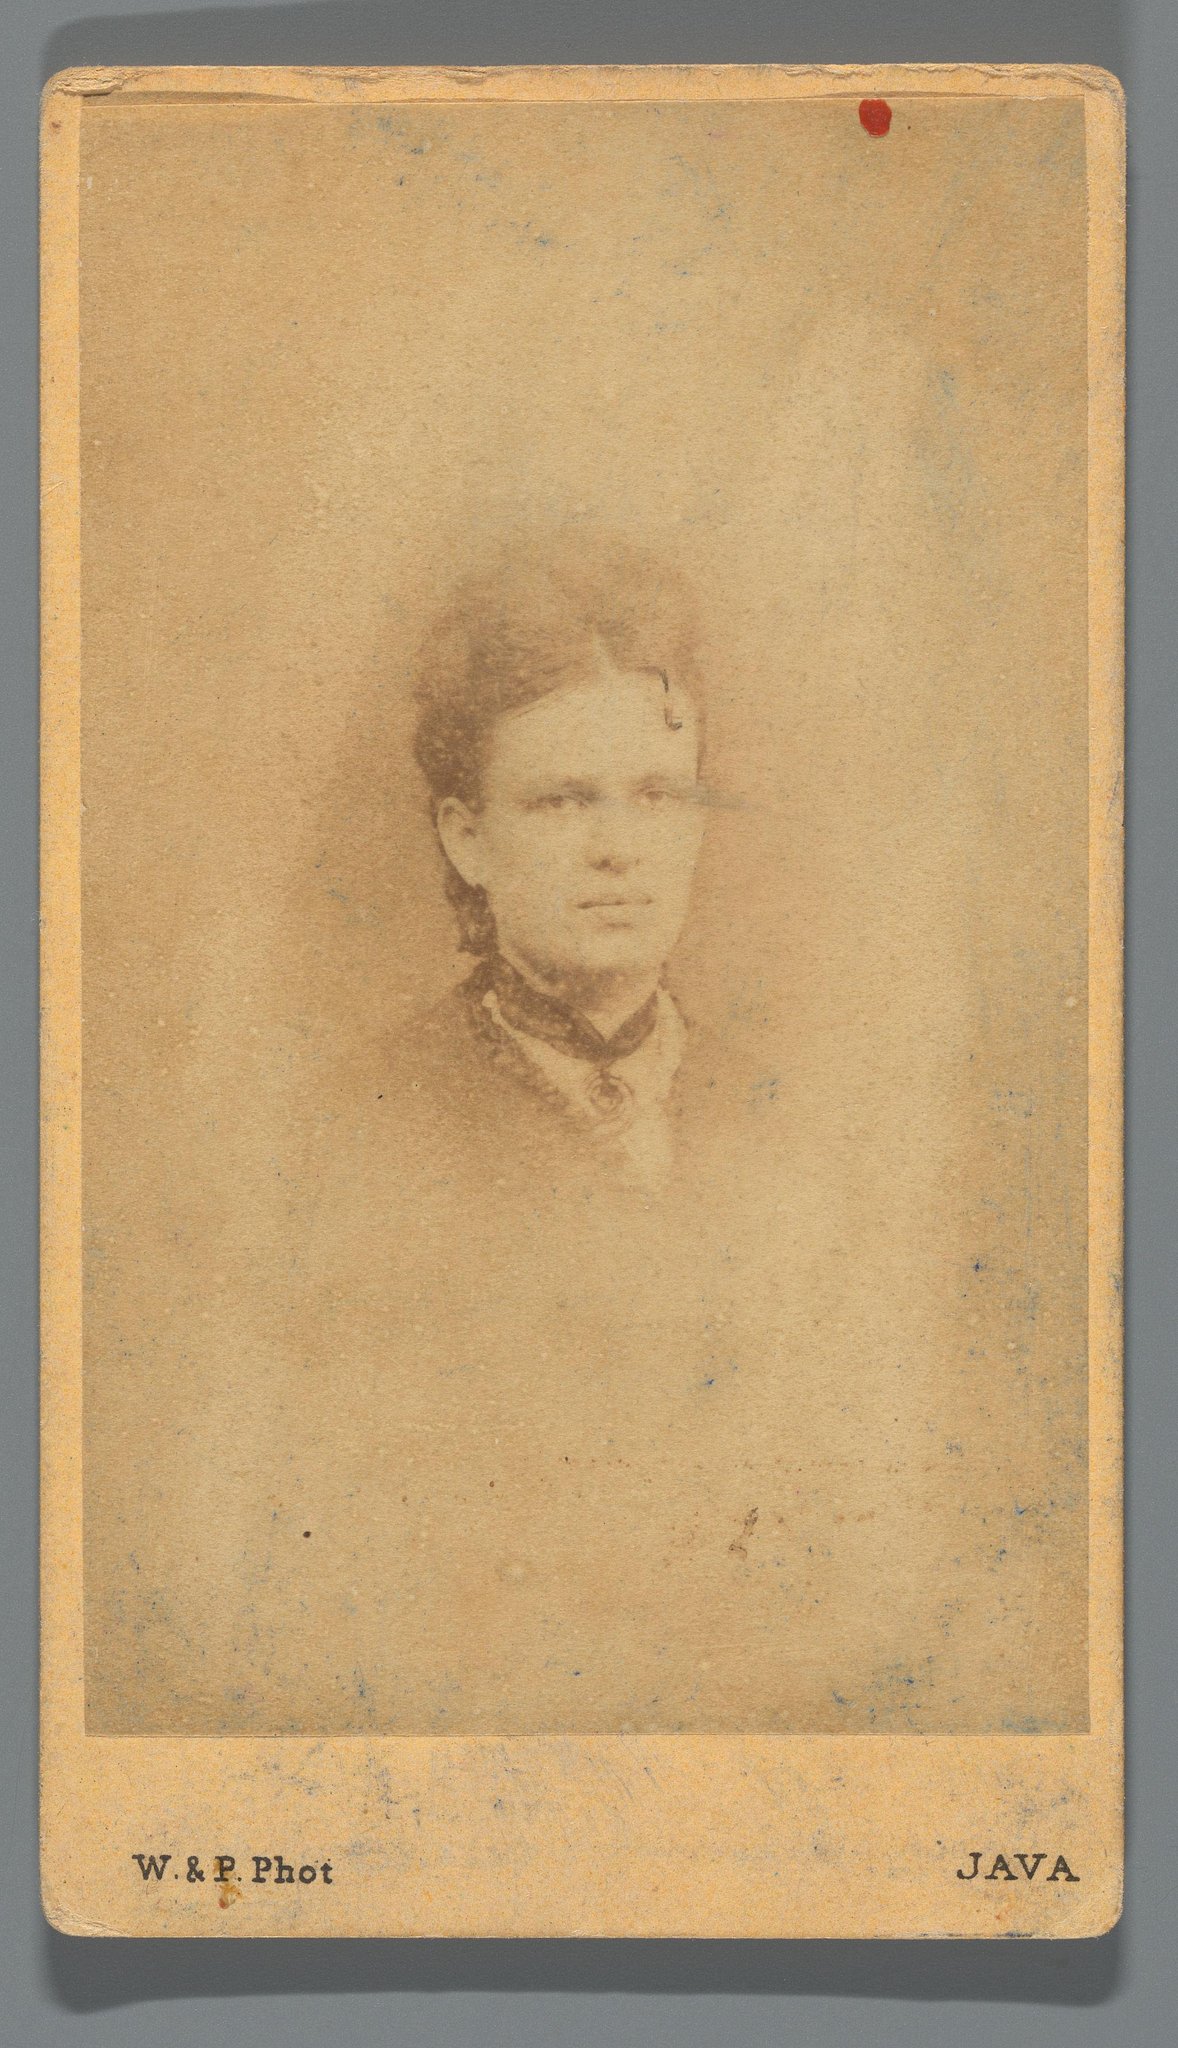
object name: photograph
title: Portret van Francina Schas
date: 1870-1890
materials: cardboard, photographic support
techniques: albumen print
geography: java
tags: francina schas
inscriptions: name: ‘Fr. vandenBerg / Schas’, name: ‘WOODBURY & PAGE , / PHOTOGRAPHERS / JAVA .’, name: ‘W.&P. Phot. JAVA’